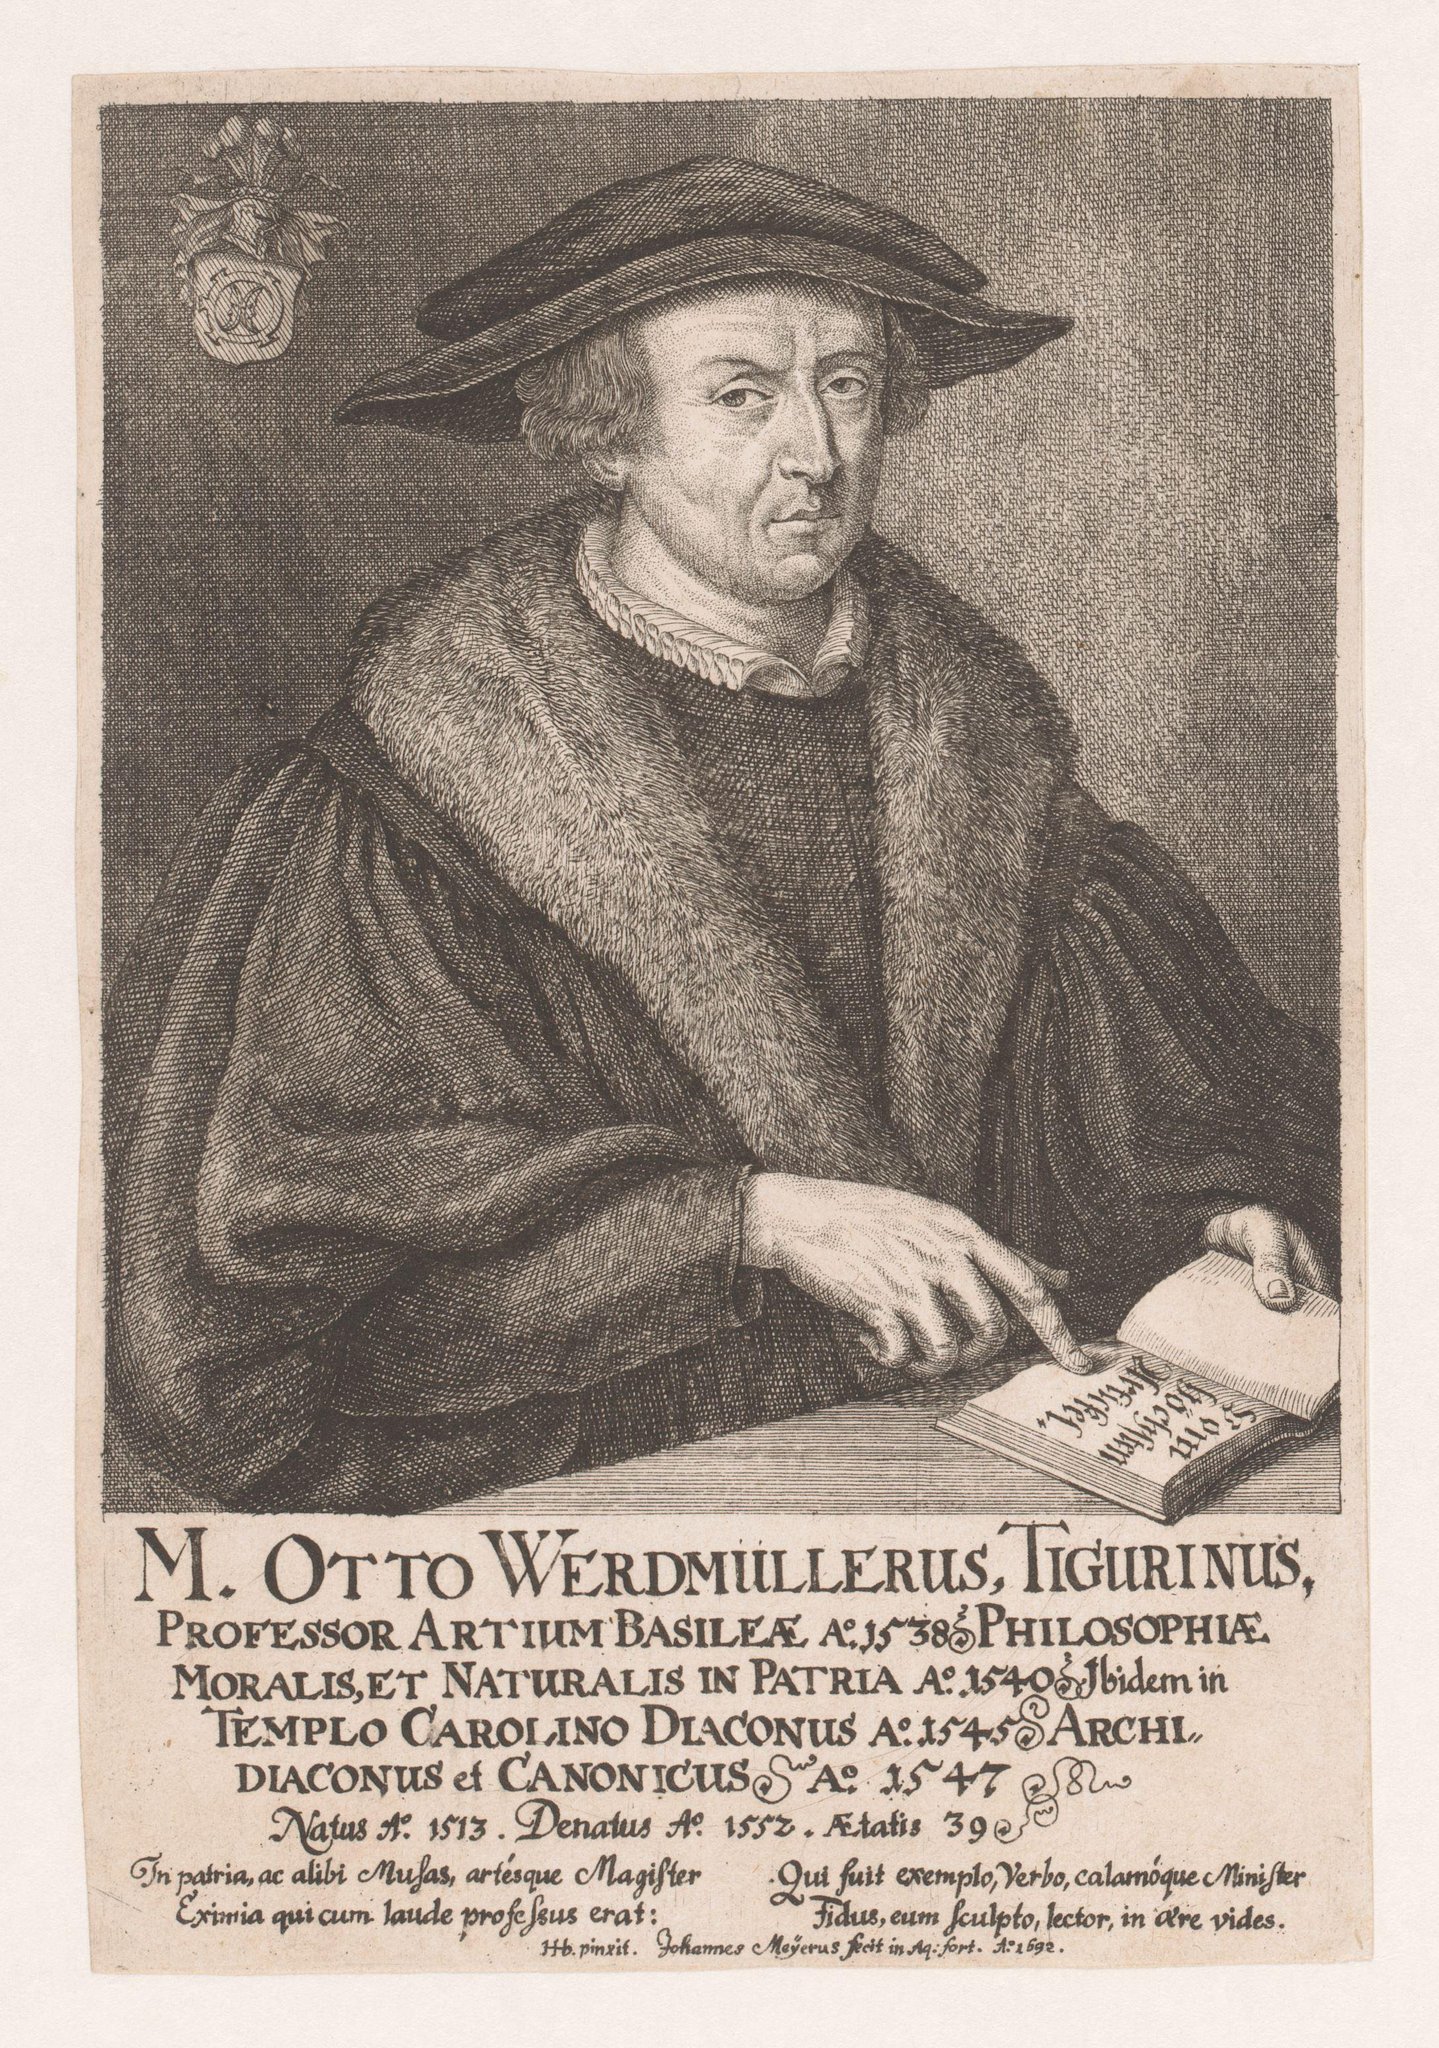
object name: print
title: Portret van Otto Werdmüller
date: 1692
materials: paper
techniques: engraving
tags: mayor, burgomaster, historical persons, armorial bearing, heraldry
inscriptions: collector's mark: Lugt 2228